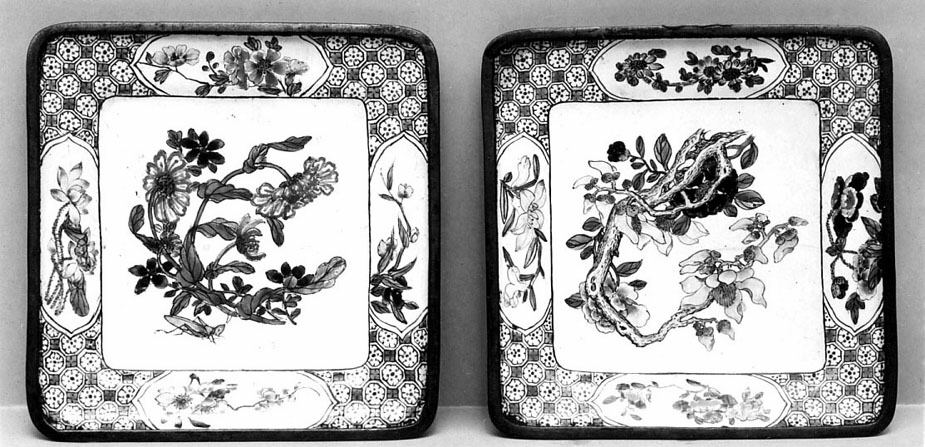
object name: dish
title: Square Dish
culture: chinese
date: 1736-1795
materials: enamel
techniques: painting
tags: flowers,plants